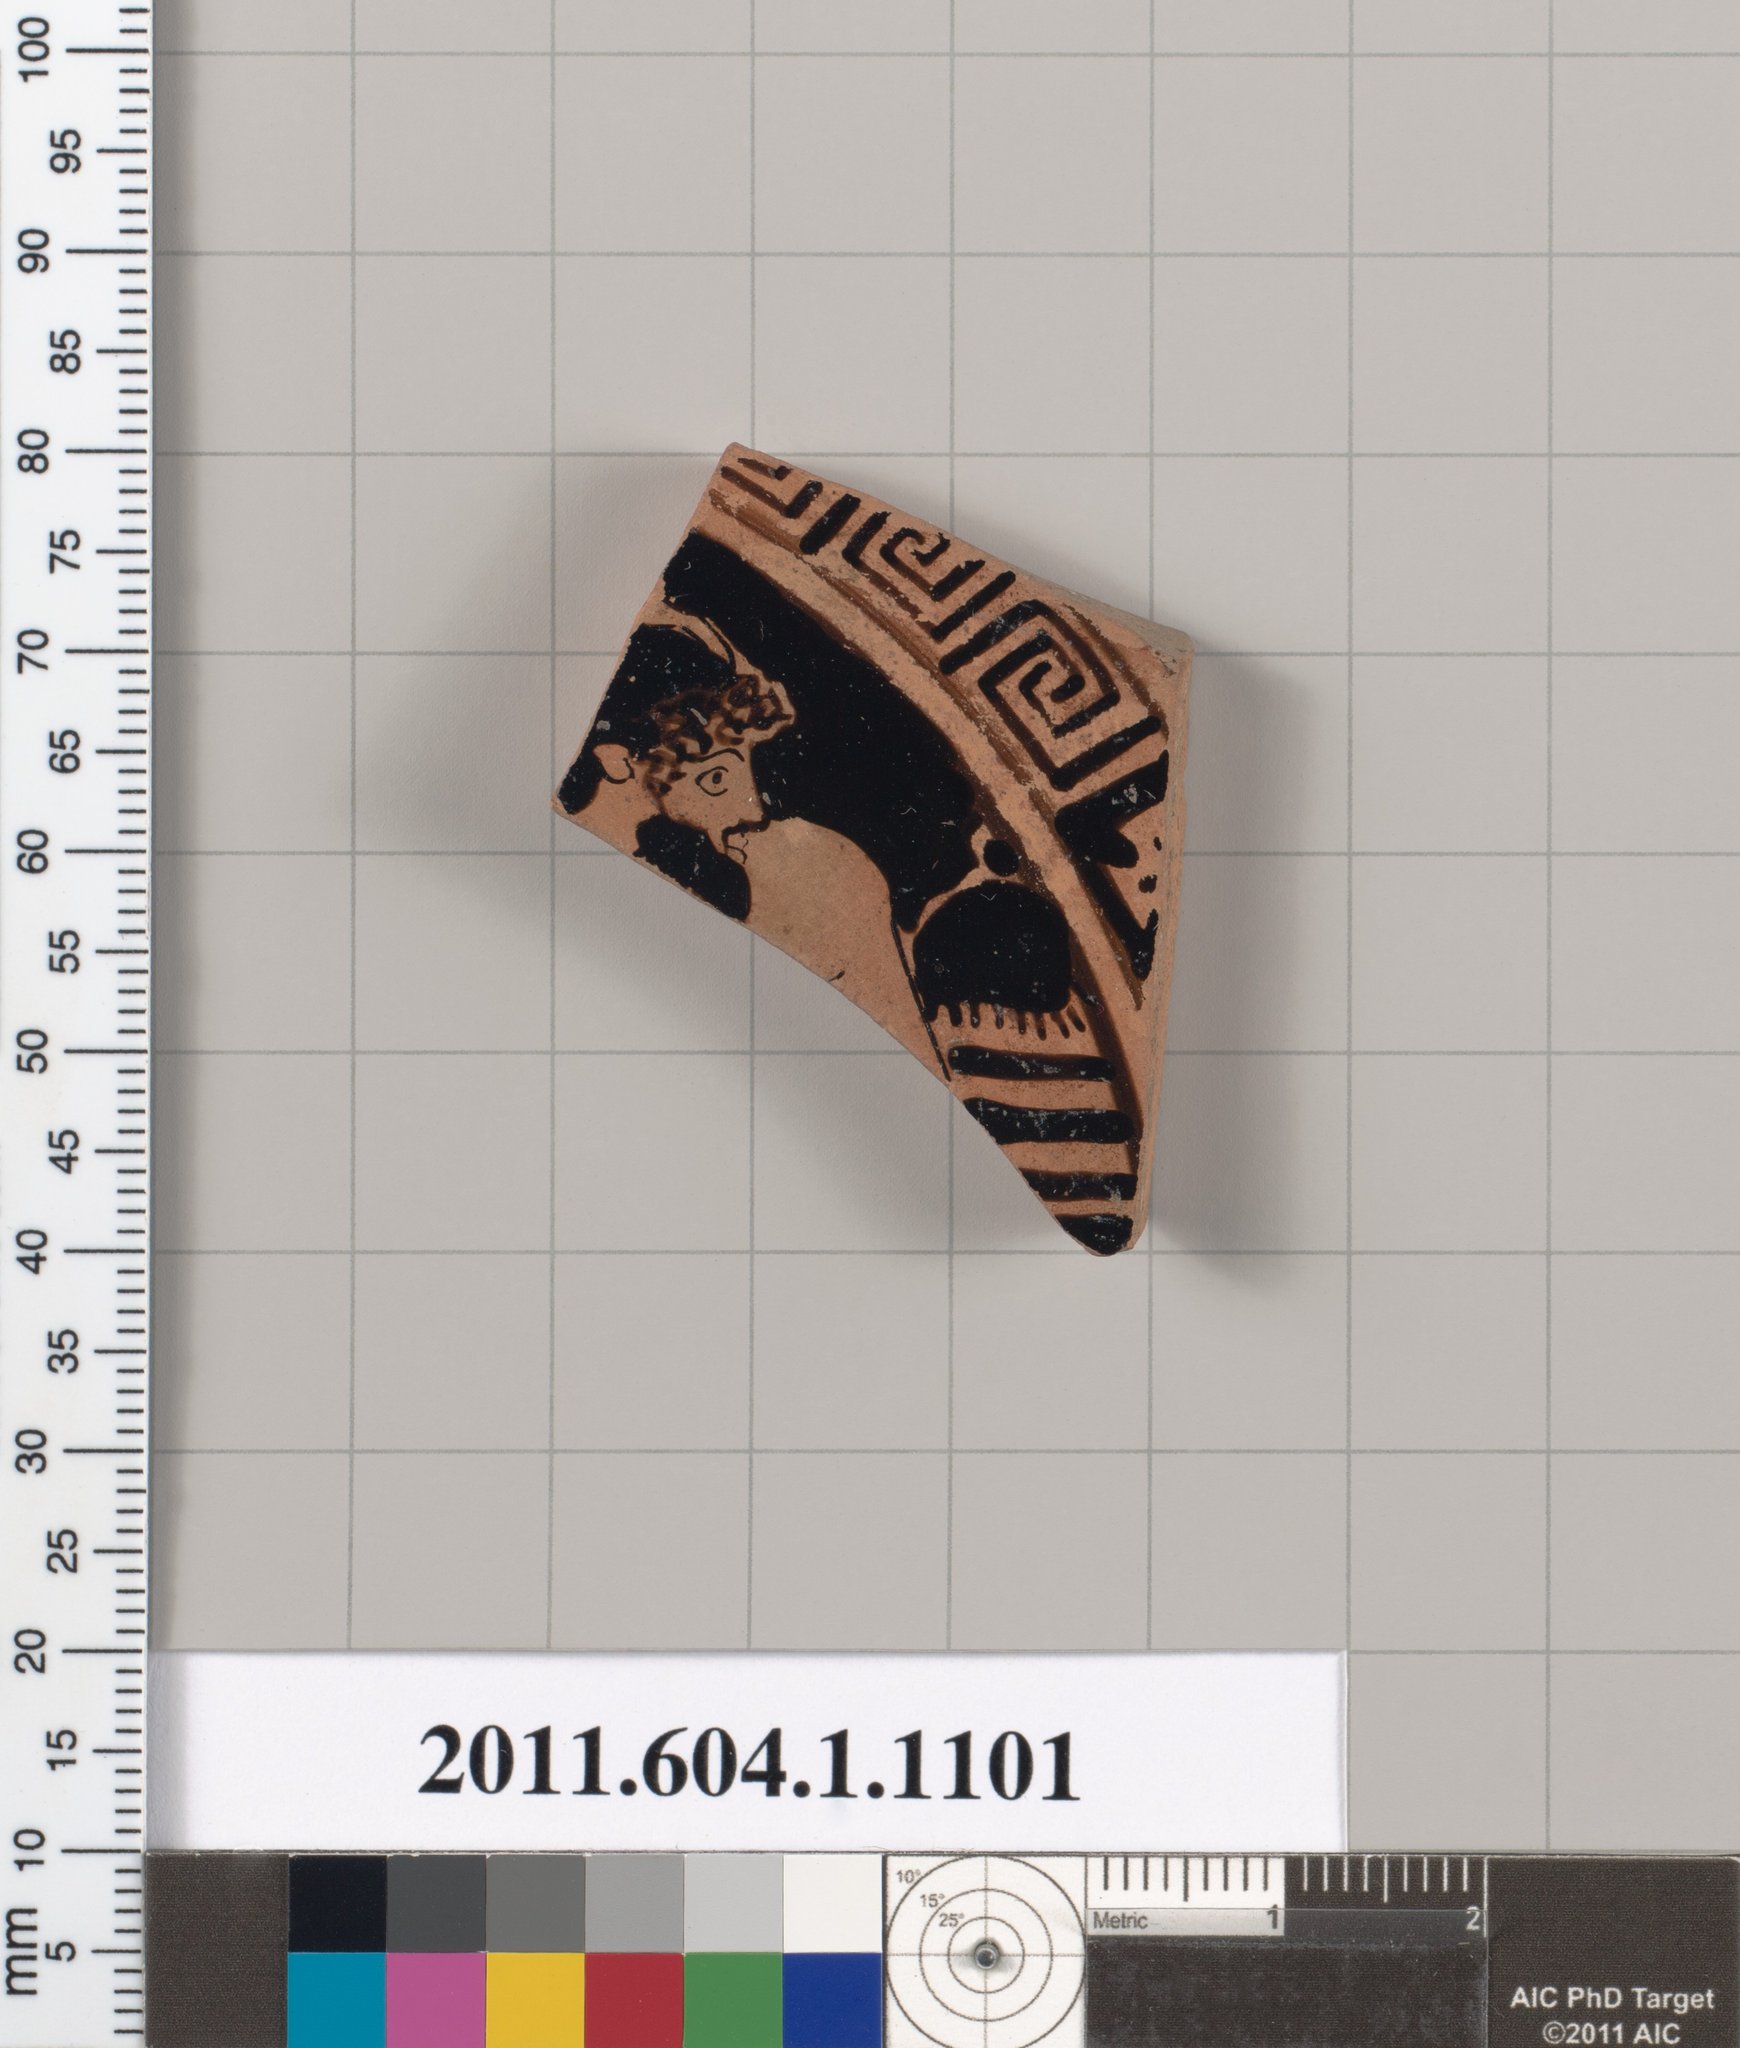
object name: kylix fragment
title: Terracotta fragment of a kylix (drinking cup)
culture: greek, attic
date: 490-480 BCE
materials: terracotta